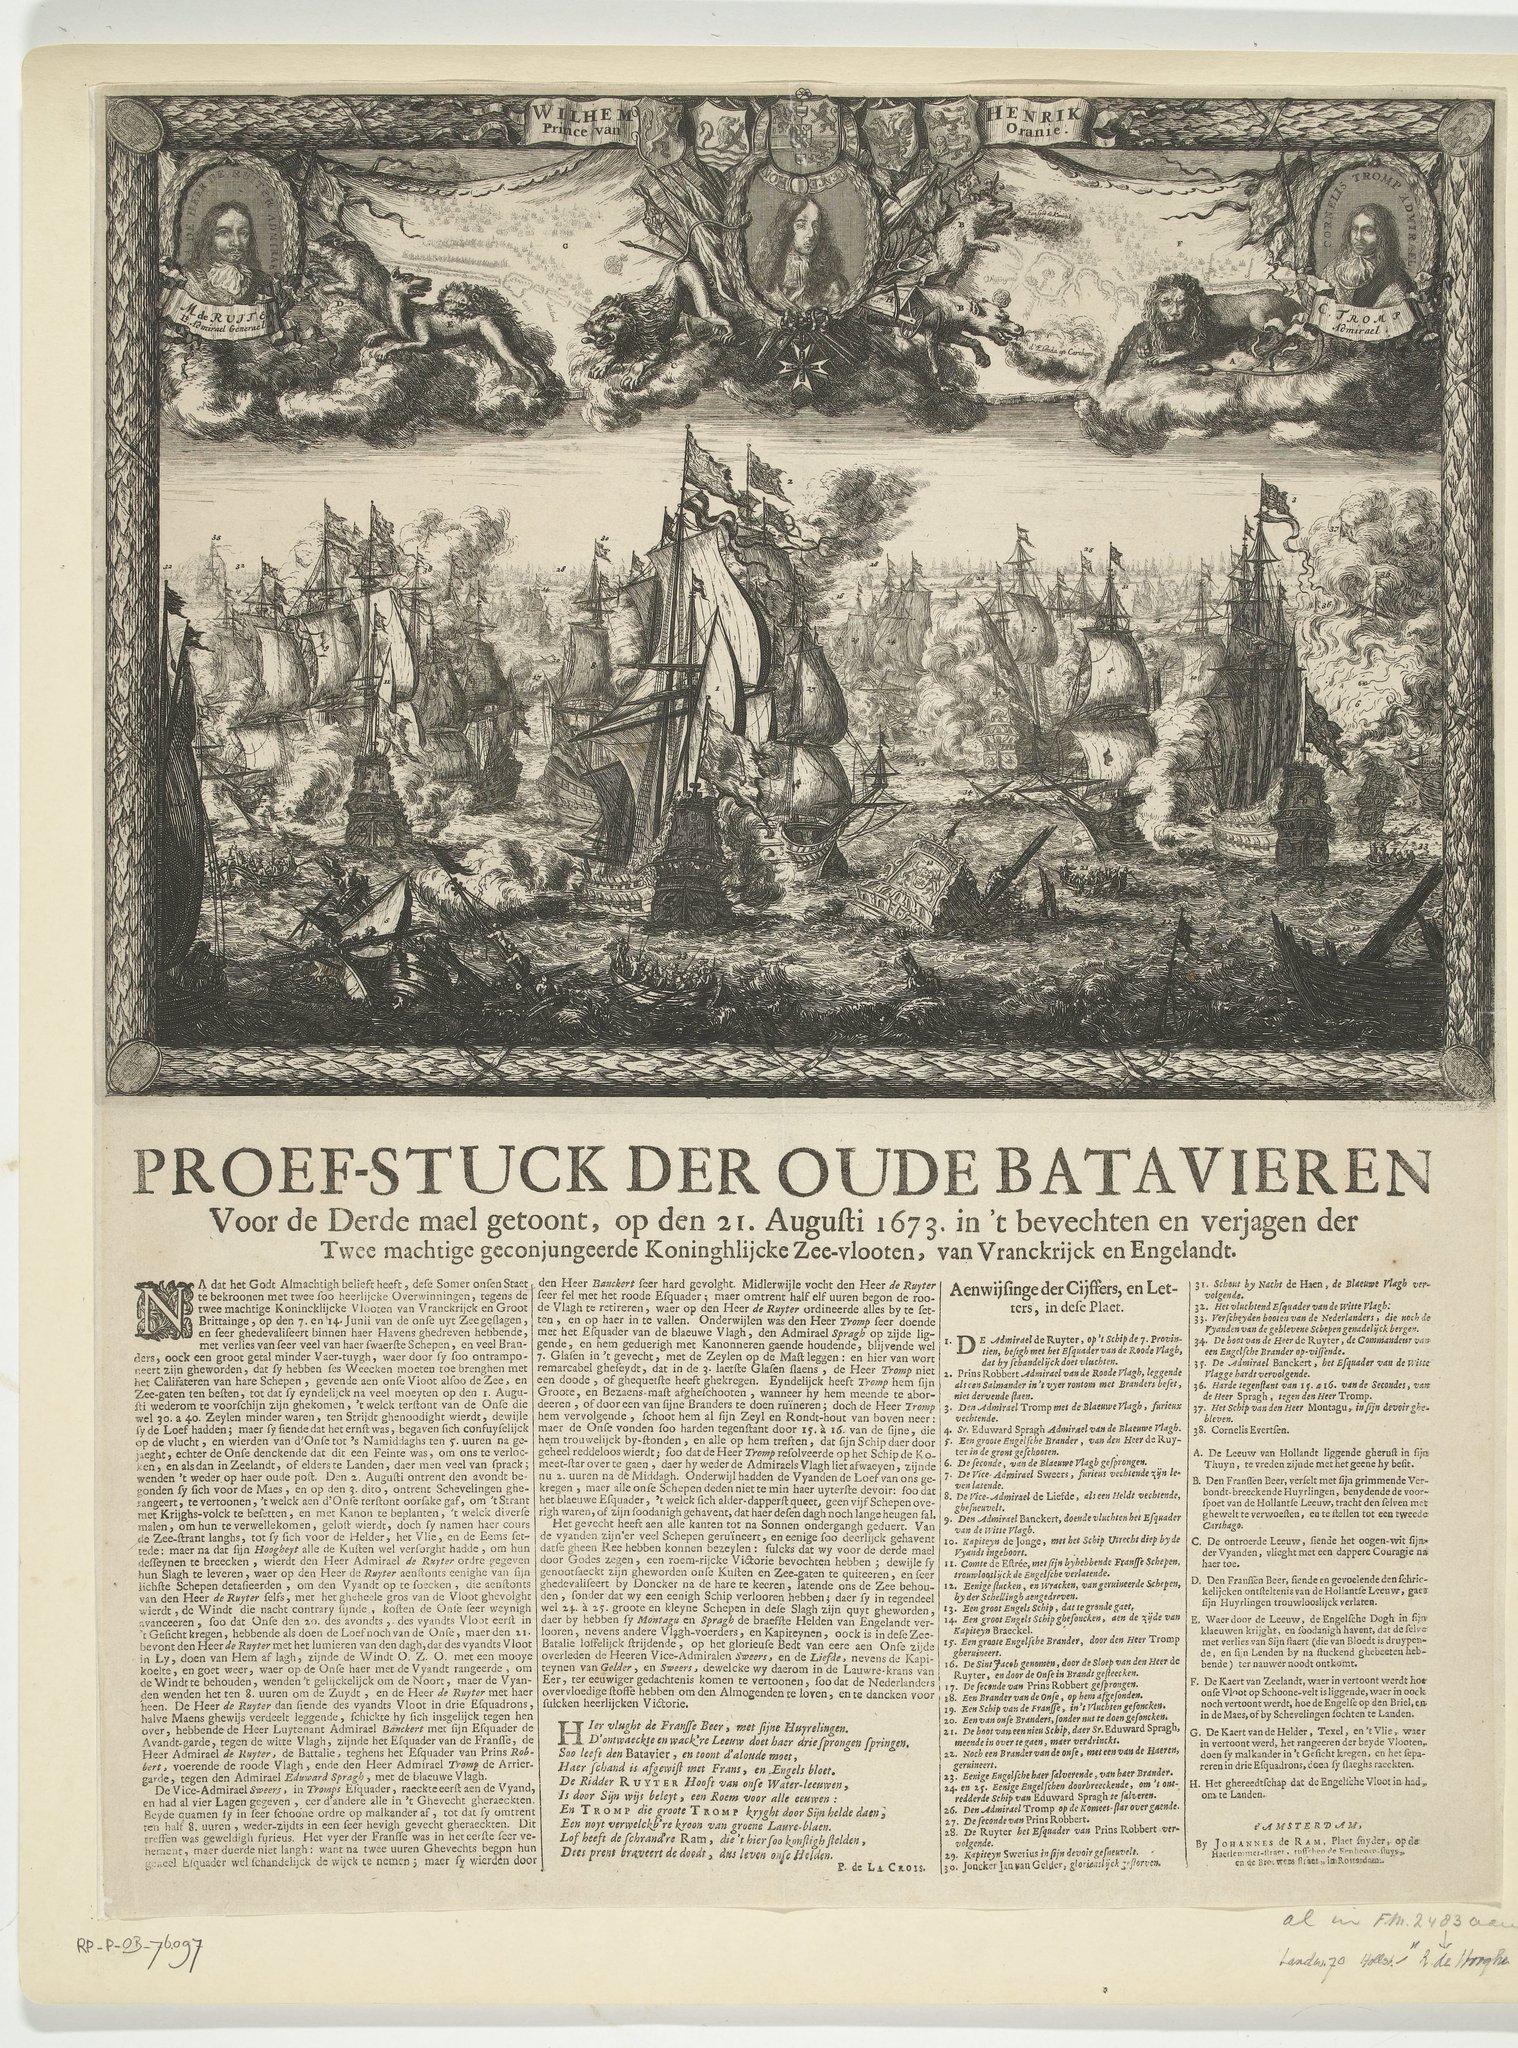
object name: print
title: Proef-stuck der oude Batavieren voor de Derde mael getoont, op den 21. Augusti 1673, in 't bevechten en verjagen der twee machtige geconjungeerde Koninghlijcke Zee-vlooten, van Vranckrijck en Engelandt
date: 1673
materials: paper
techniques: etching, letterpress printing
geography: netherlands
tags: flushing, michiel adriaenszoon de ruyter, rotterdam, amsterdam, cornelis tromp, the hague, william iii (prince of orange and king of england, scotland, and ireland), battle (+ naval force), battle of the texel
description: Zeeslag bij Kijkduin, 21 augustus 1673. Zeeslag tussen de Staatse vloot onder Michiel Adriaenszoon de Ruyter en Tromp en de gecombineerde Engels-Franse vloot onder prins Rupert. Boven de slag in het midden het portret van Willem III, links portret van De Ruyter, rechts van Tromp. Onder de plaat een tekstblad met beschrijving van de slag, een vers en de legenda's 1-38 en A-H.